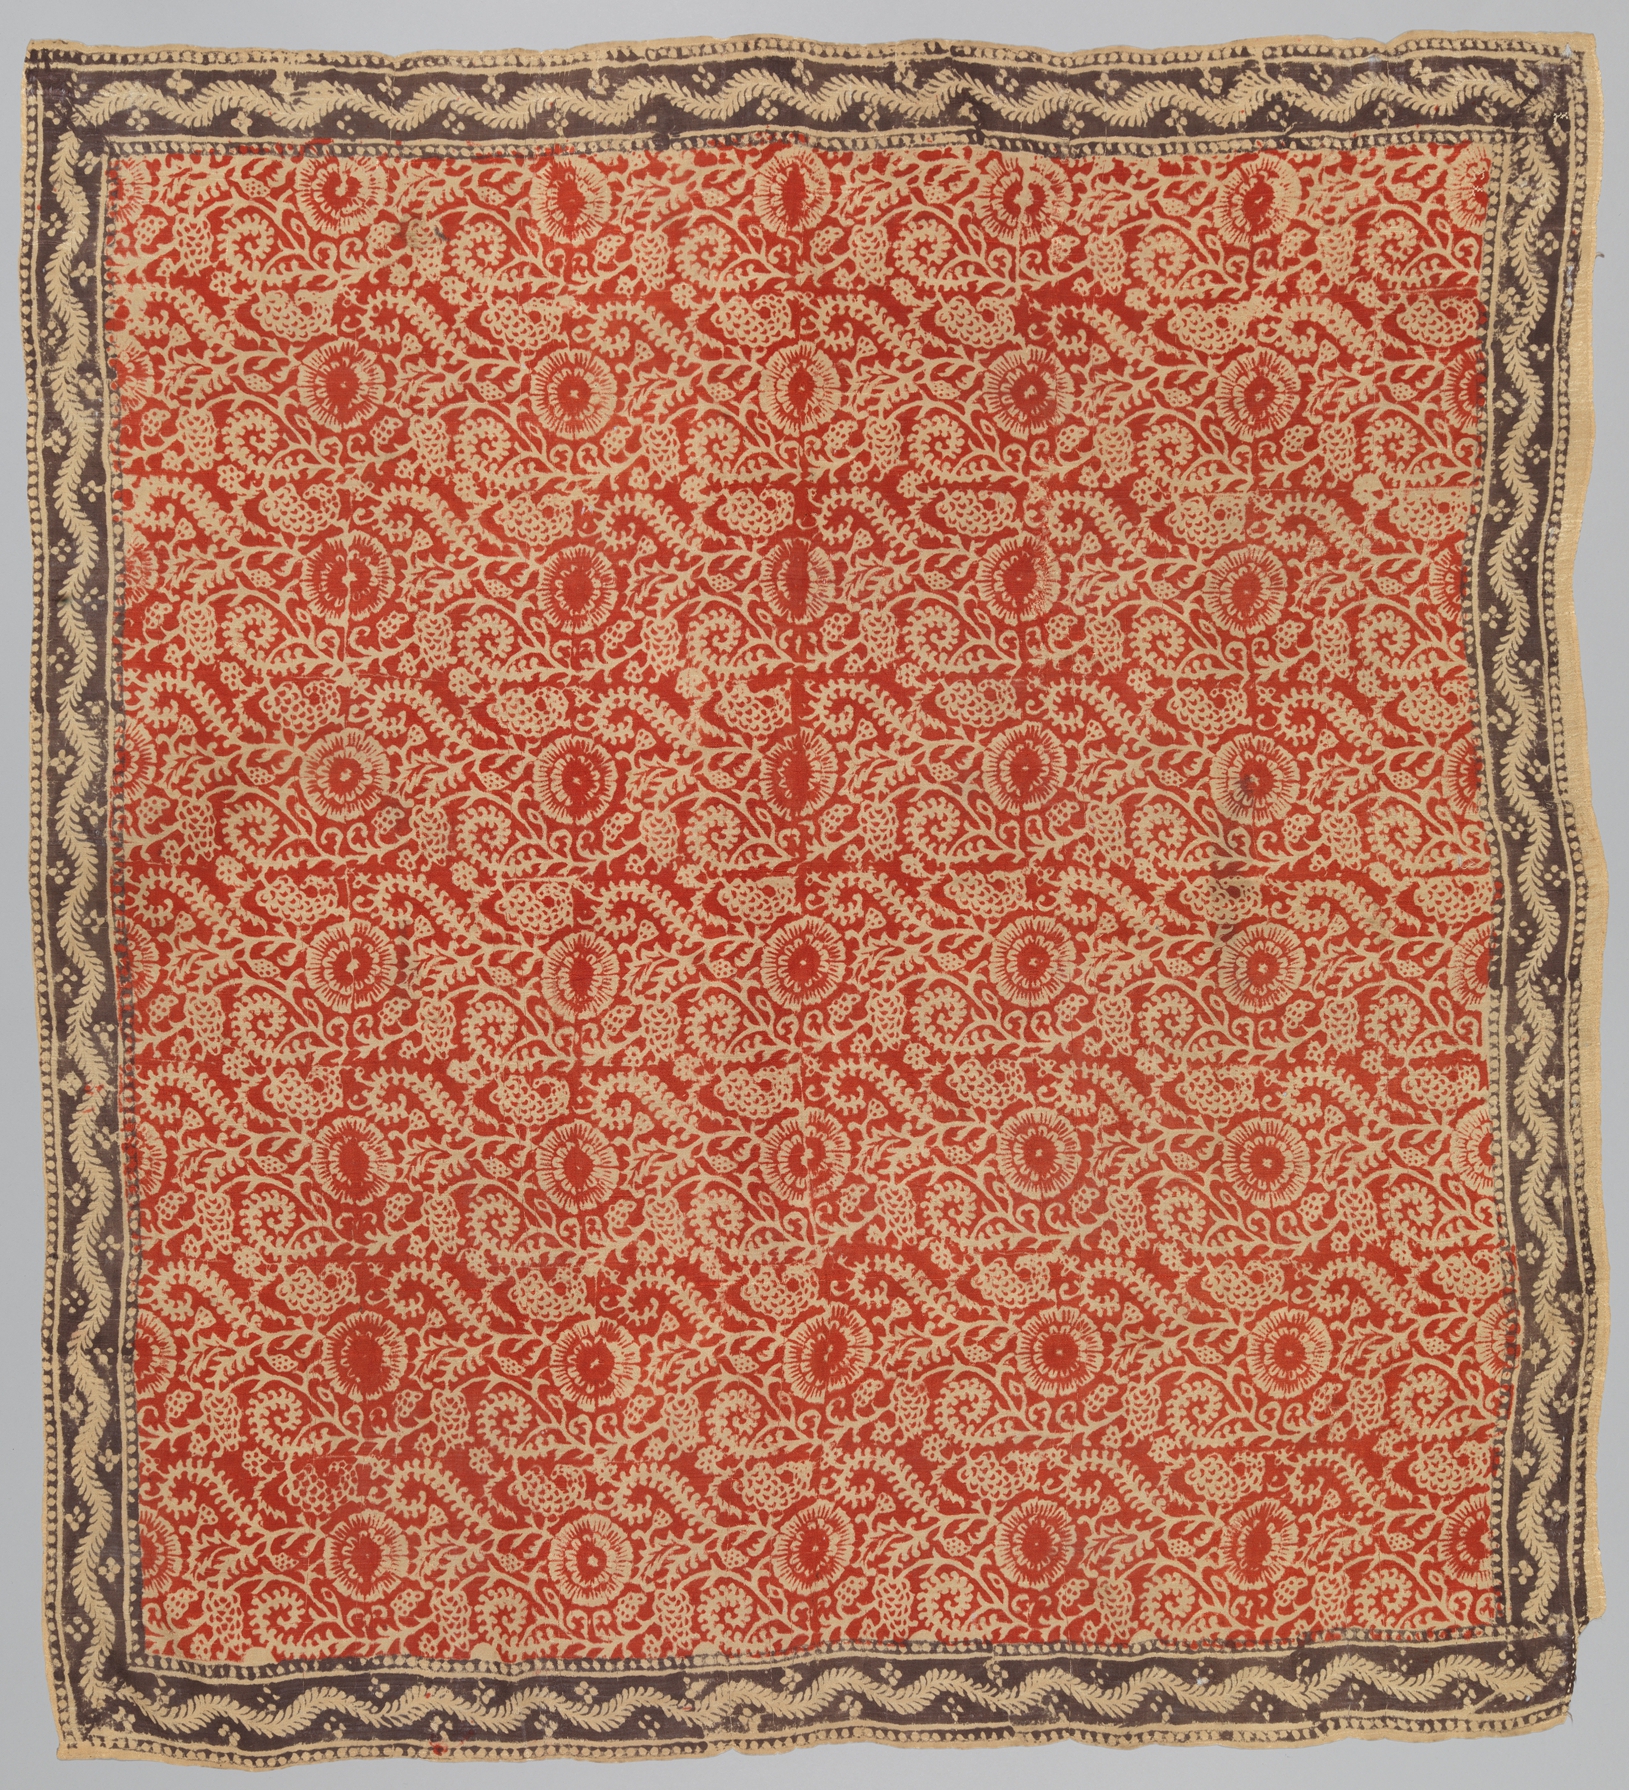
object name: handkerchief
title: Man's handkerchief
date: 1801-1900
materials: silk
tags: flowers